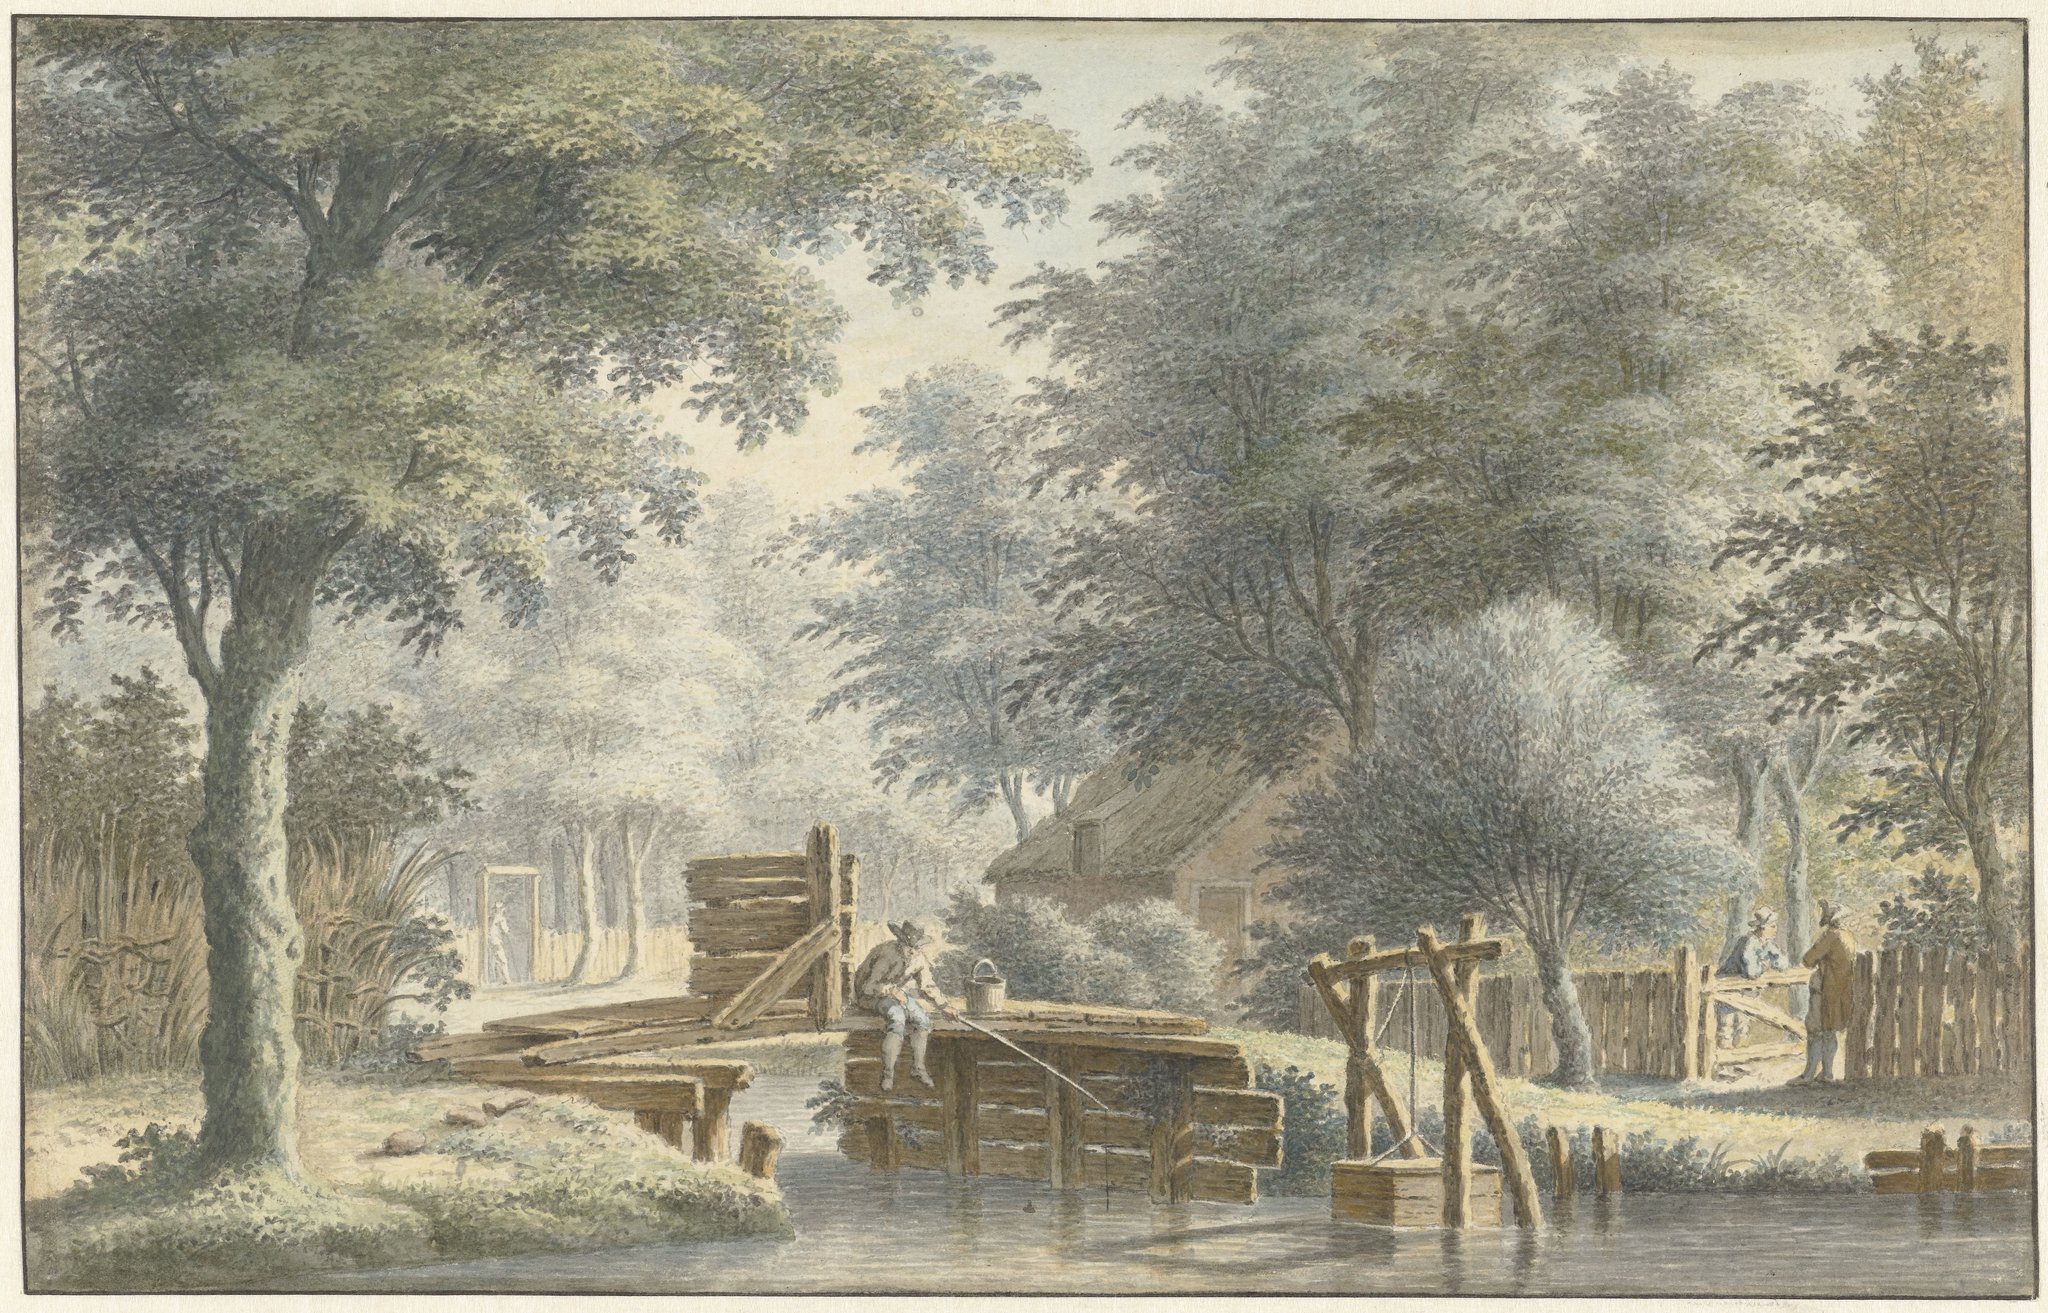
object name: drawing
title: Landschap met een brug waarop een hengelaar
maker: gerard van rossum (1698/99-1772)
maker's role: draughtsman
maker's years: 1698-1772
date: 1763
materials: chalk, paper, watercolor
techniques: brush